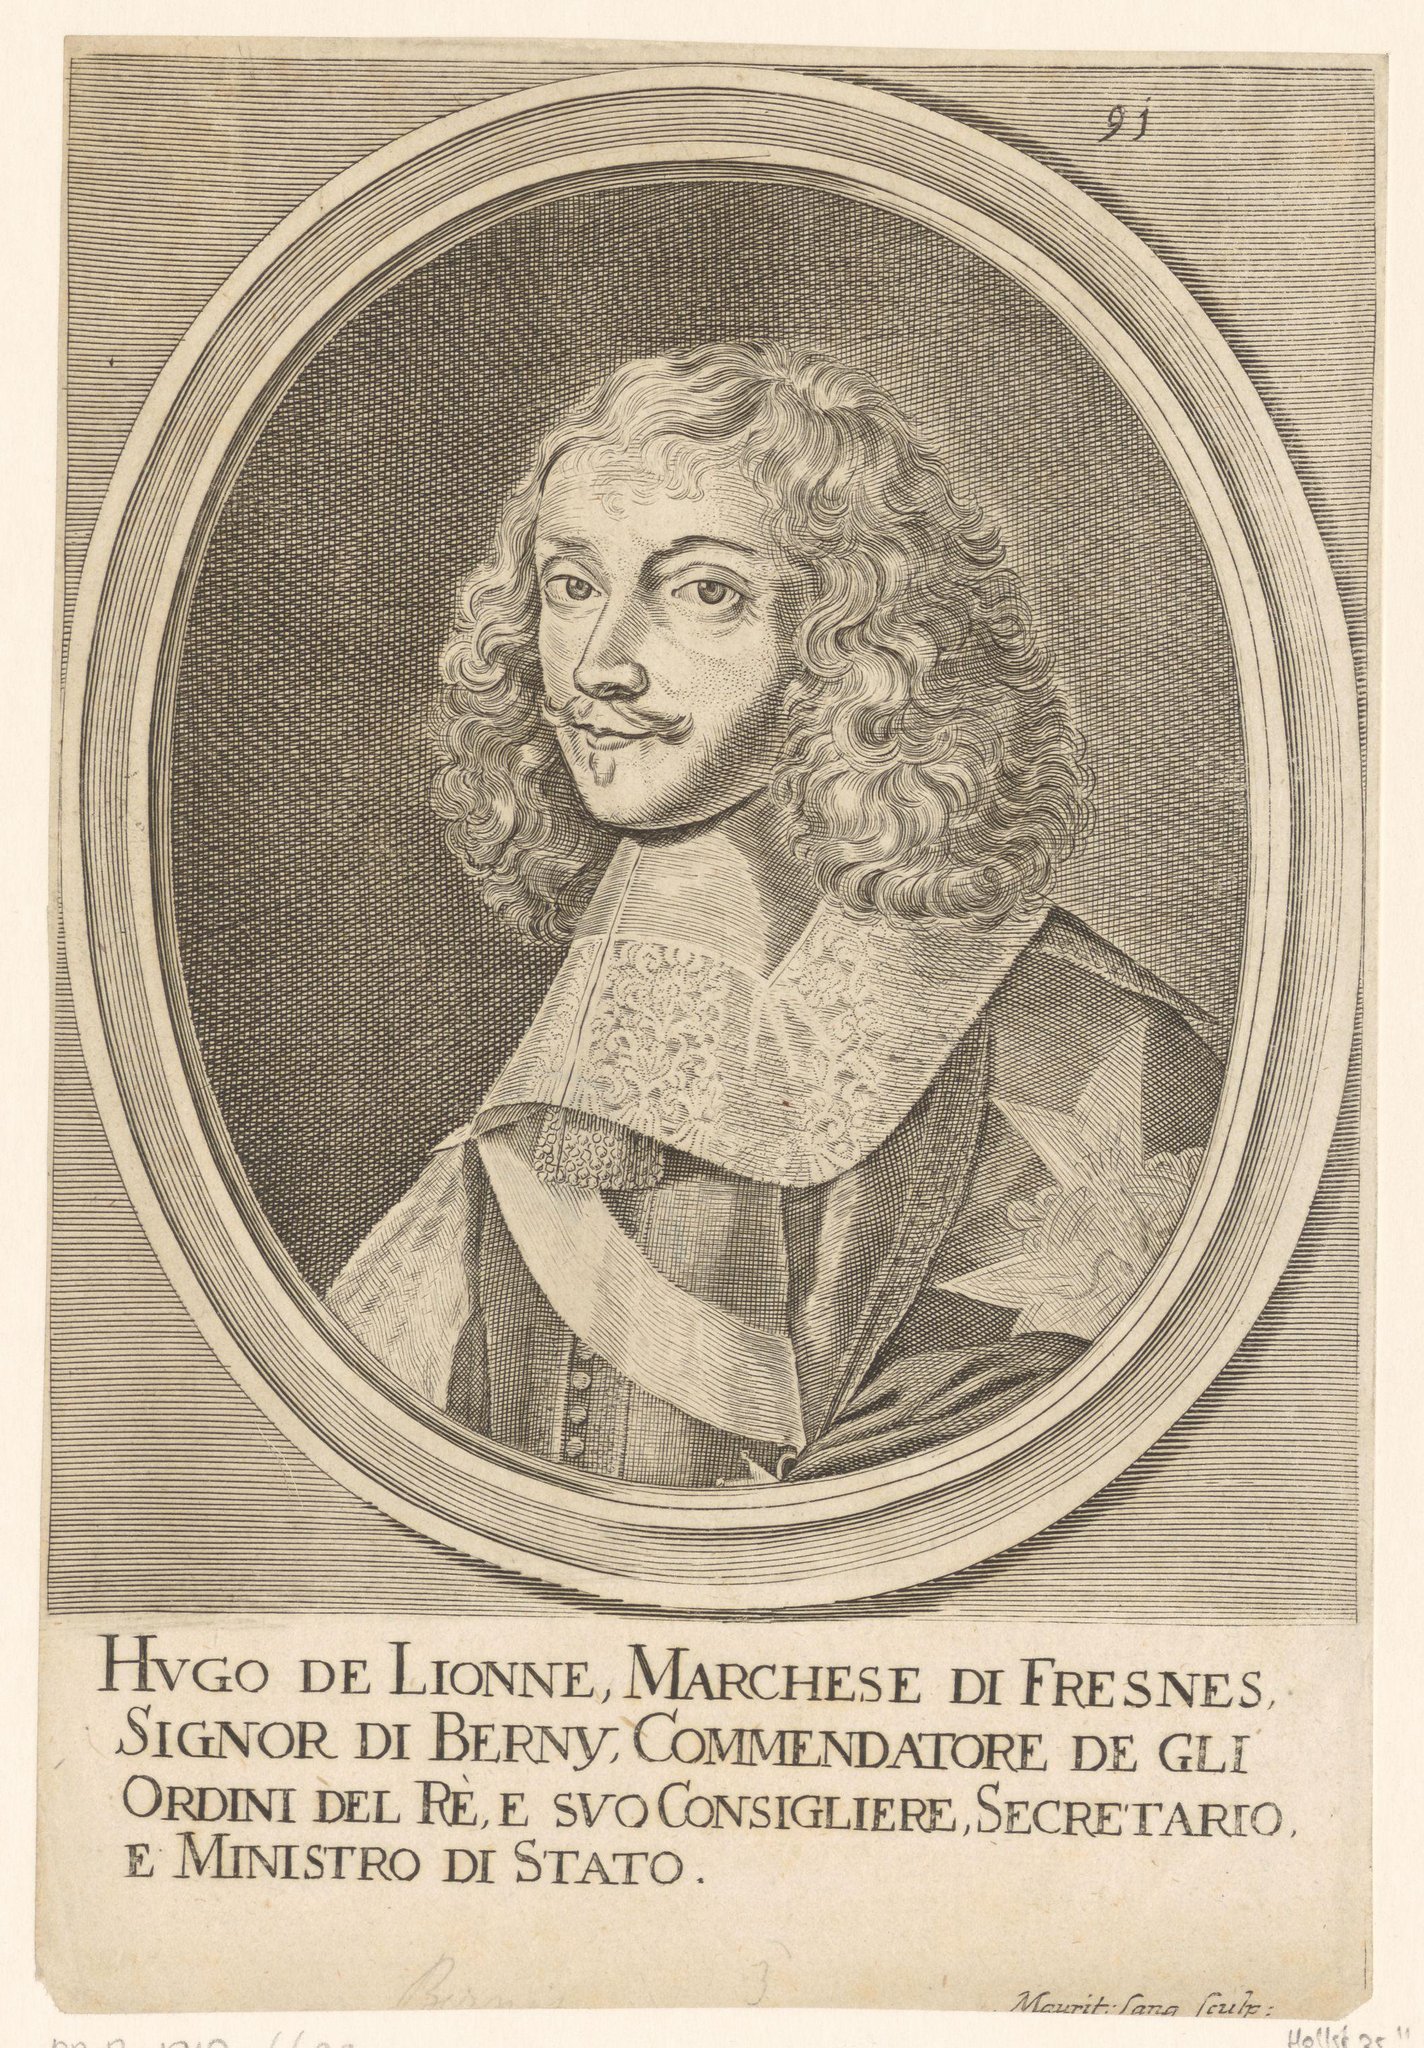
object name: print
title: Portret van Hugues de Lionne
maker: moritz lang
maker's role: draughtsman, print maker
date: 1649-1670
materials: paper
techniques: engraving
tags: paris, historical persons, lawyer, attorney at law, diplomacy, diplomat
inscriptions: collector's mark: Lugt 2228, annotation: ‘9j’